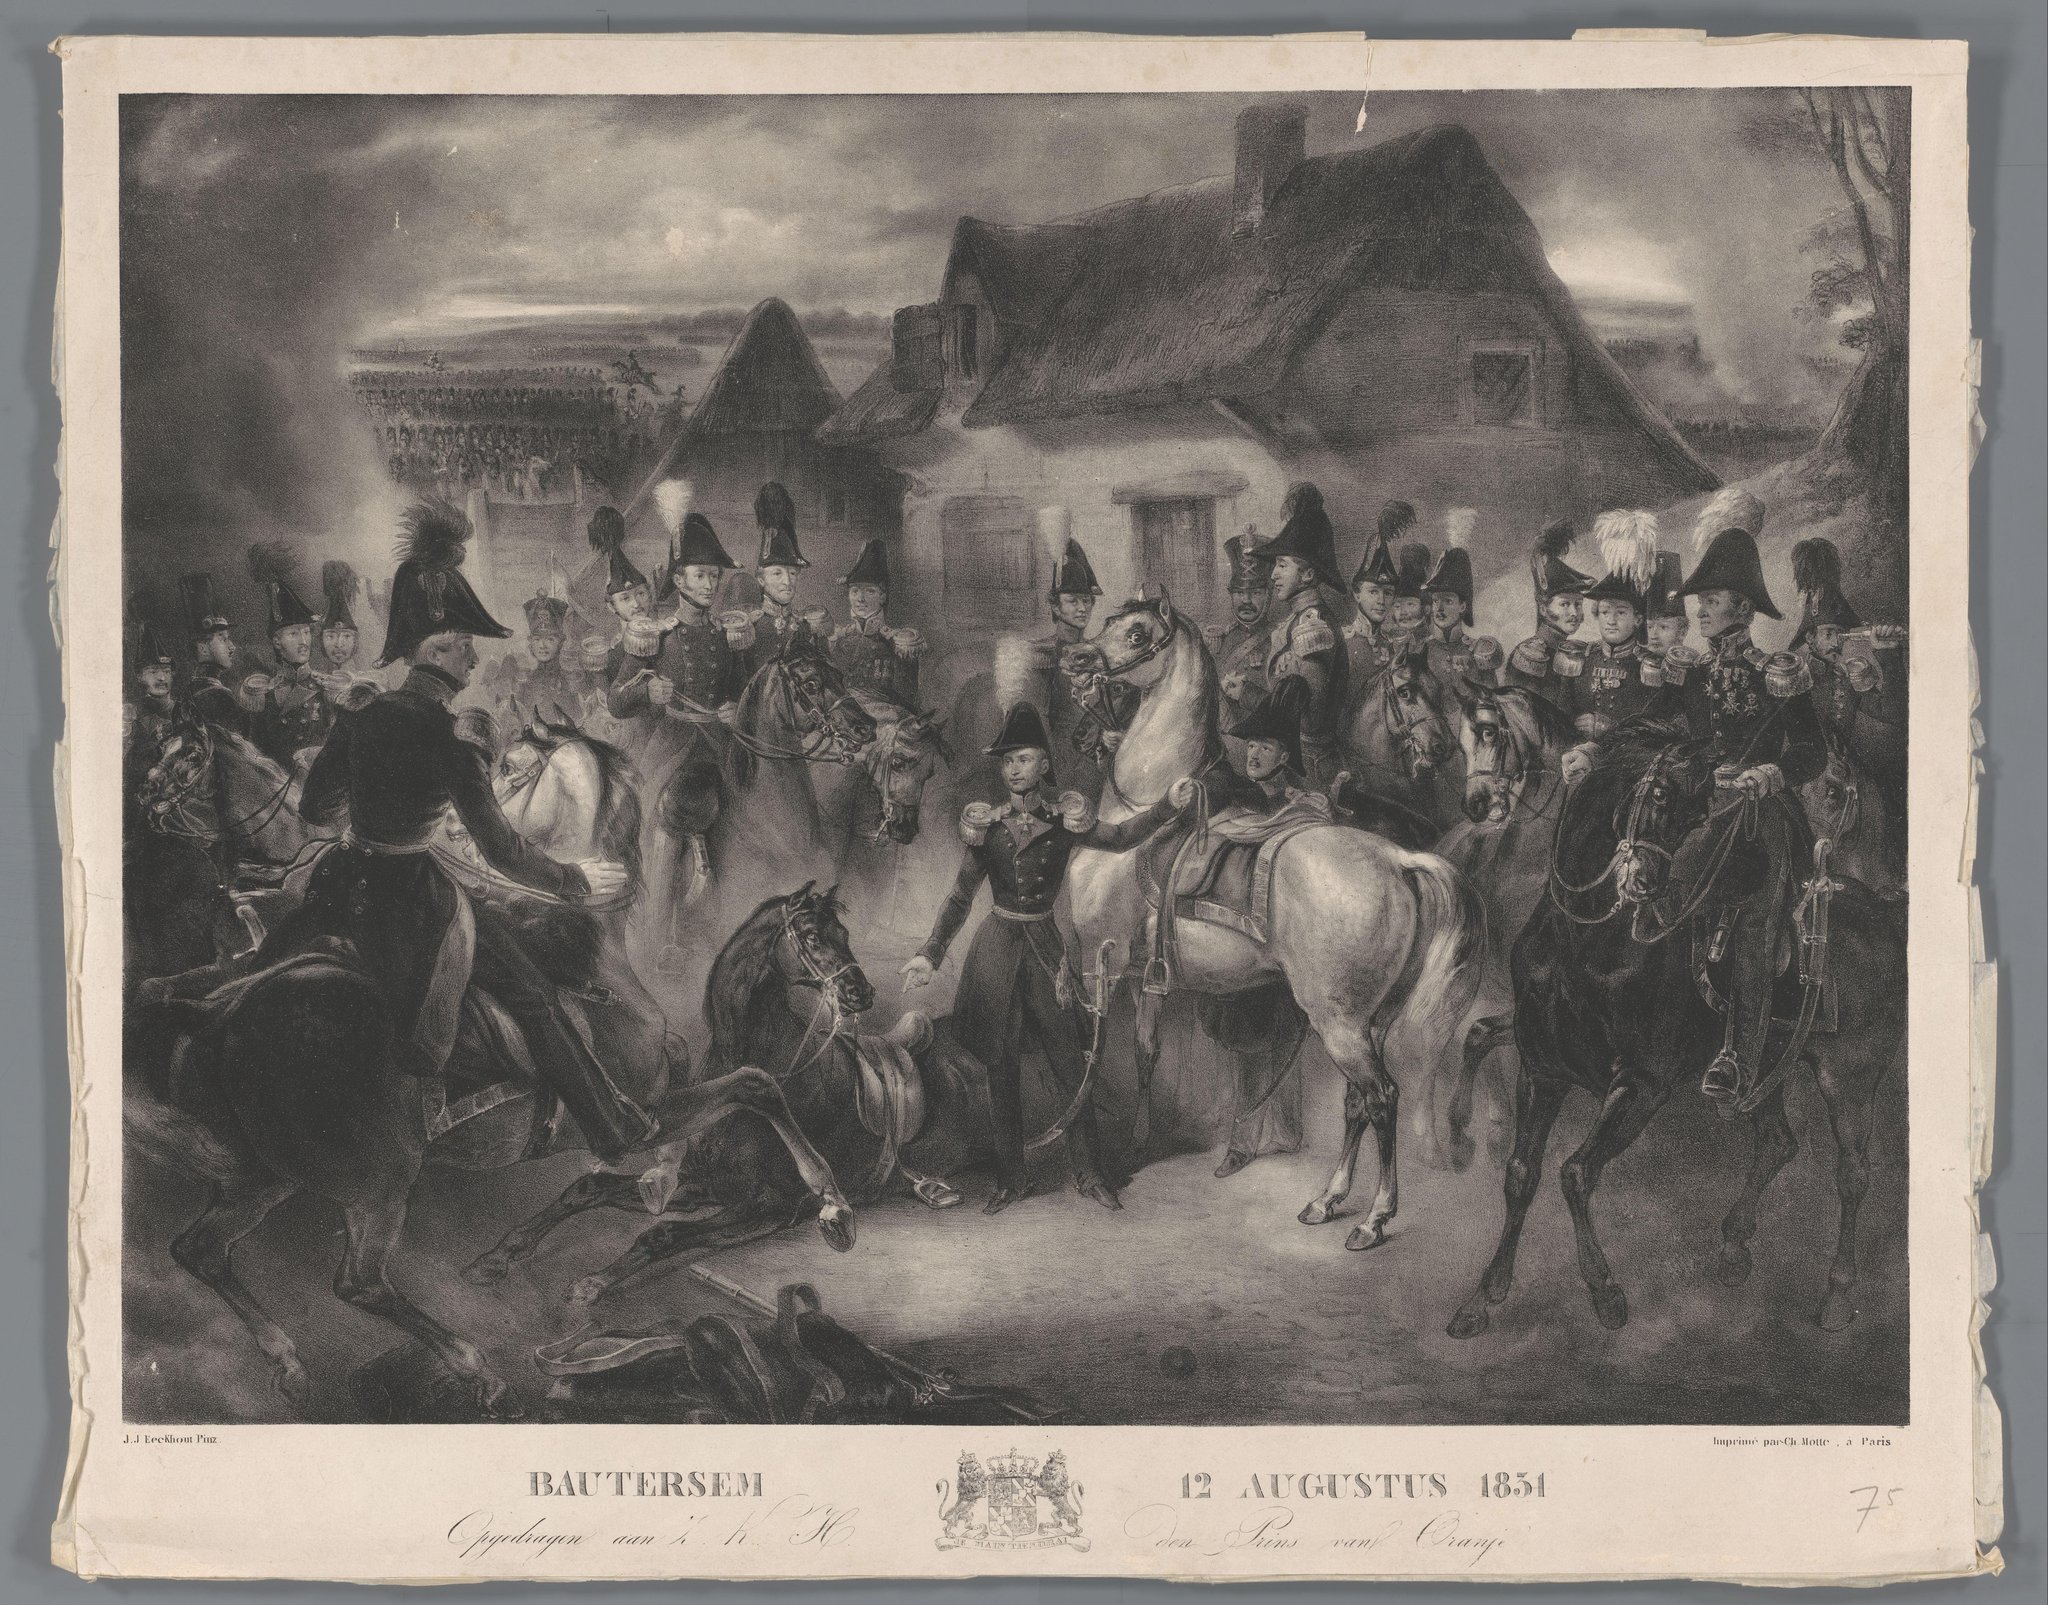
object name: print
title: Bautersem 12 augustus 1831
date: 1831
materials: paper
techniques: lithograph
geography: france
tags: the hague, william ii of the netherlands, battle (+ cavalry, horsemen), horse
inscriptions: caption: ‘BAUTERSEM 12 AUGUSTUS 1831 / Opgedragen aan Z.K.H. den Prins van Oranje’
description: Het paard van de prins van Oranje raakt gewond in de slag bij Boutersem, 12 augustus 1831. De prins wordt een ander paard aangereikt. Achter de prins rijdt prins Frederik te paard met zijn adjudanten en andere officieren. Bij de prent behoort een sleutelprent met de namen van de voorgestelden. In het onderschrift het wapen van de prins van Oranje.